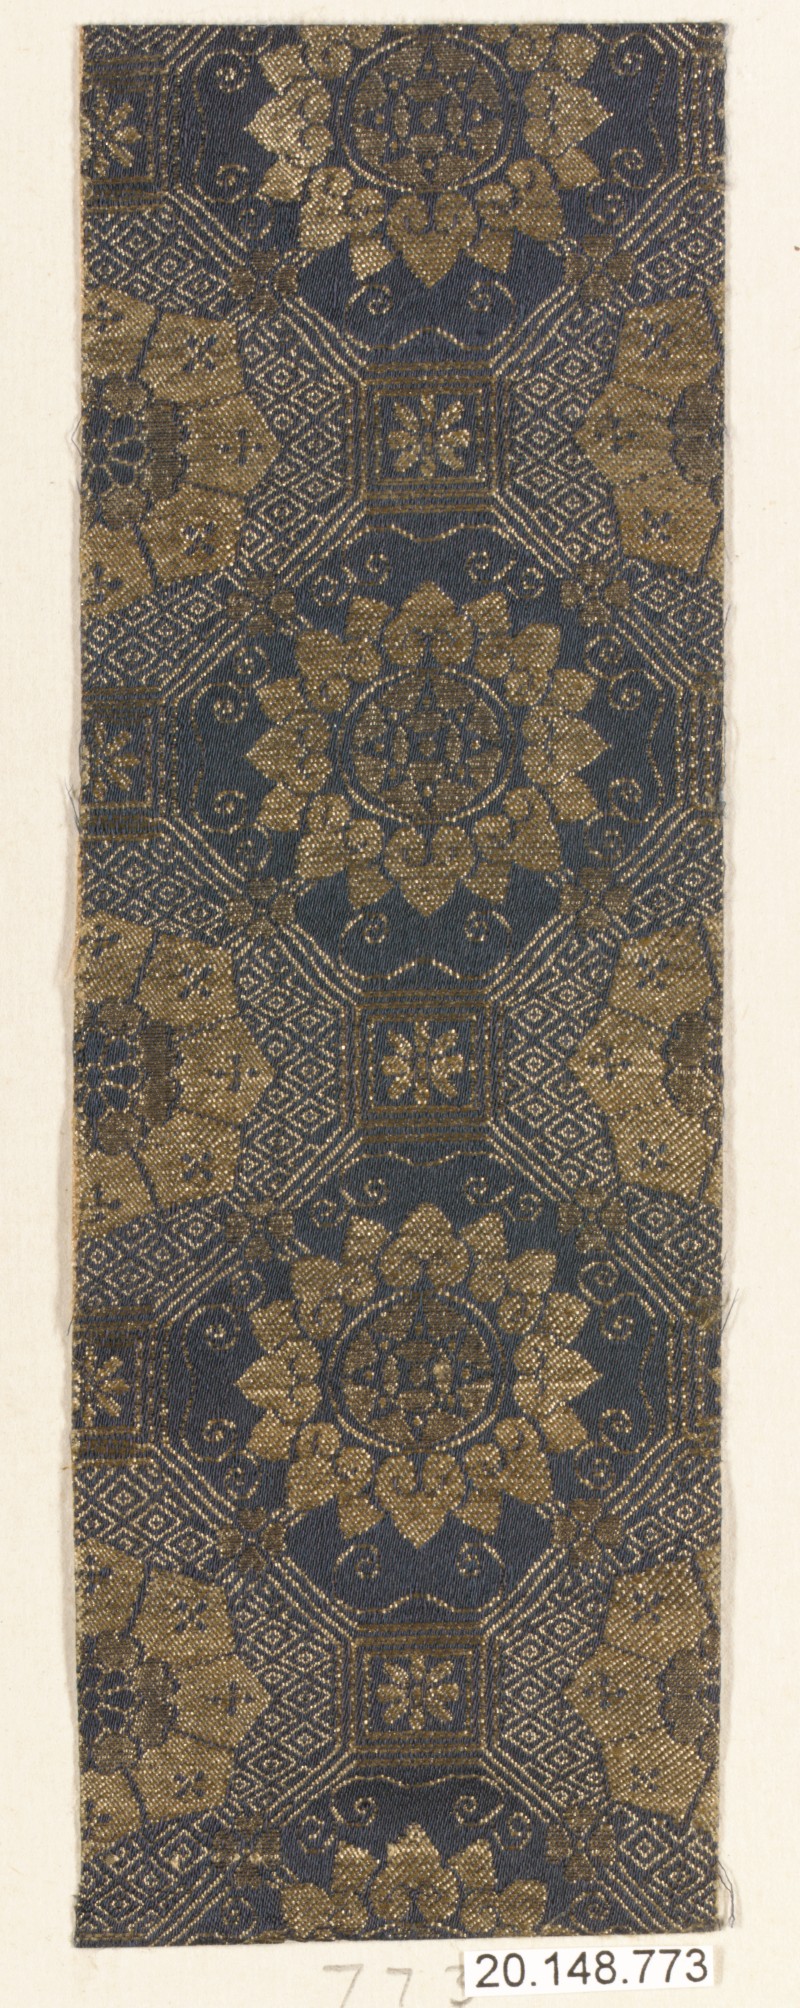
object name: piece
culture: japanese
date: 1601-1700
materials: silk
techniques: compound weave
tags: flowers